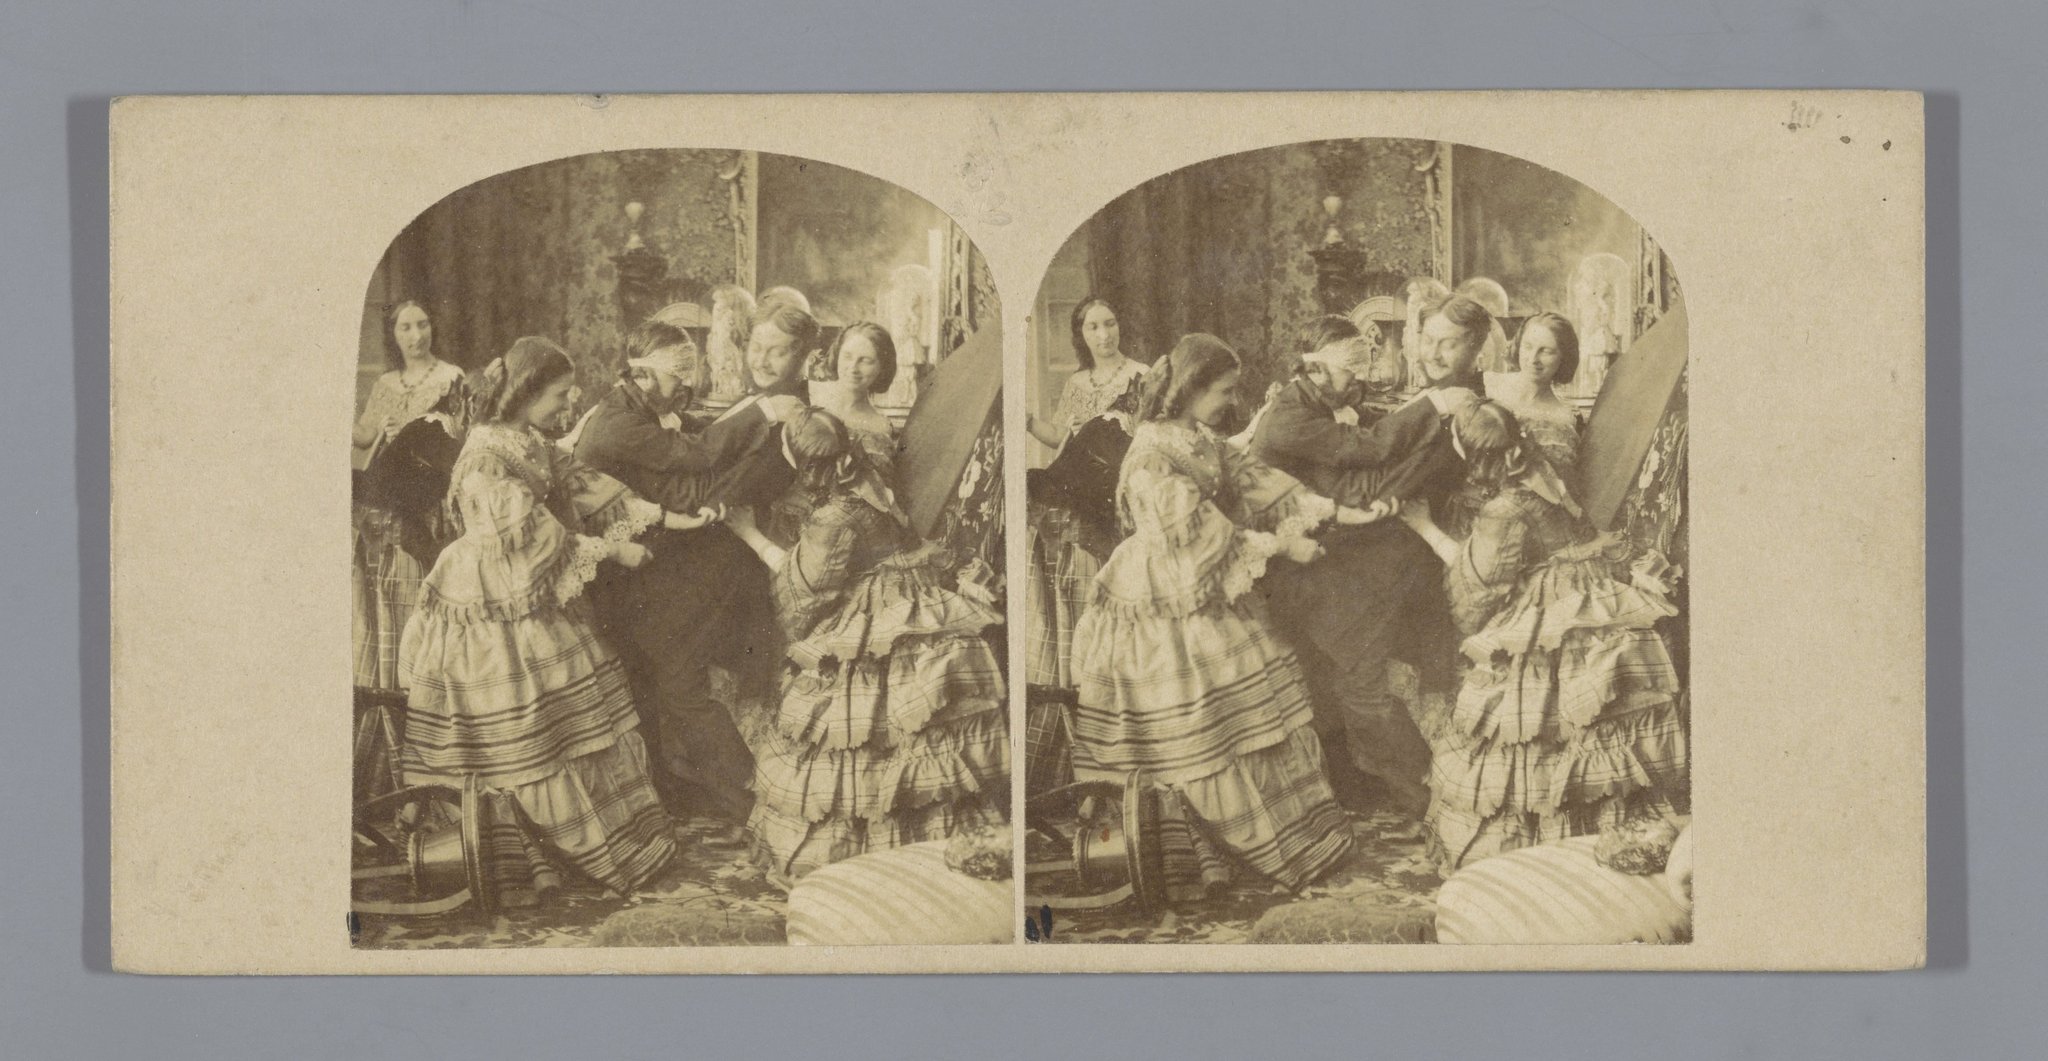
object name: stereograph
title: Caught at last, pretty creature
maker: james elliott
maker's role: publisher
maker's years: 1832-1900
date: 1850-1880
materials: cardboard, photographic support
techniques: albumen print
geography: england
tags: blindfold games, england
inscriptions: name: ‘J. Elliot.’, number: ‘60.’, inscription: ‘Entered at Stationers' Hall.’